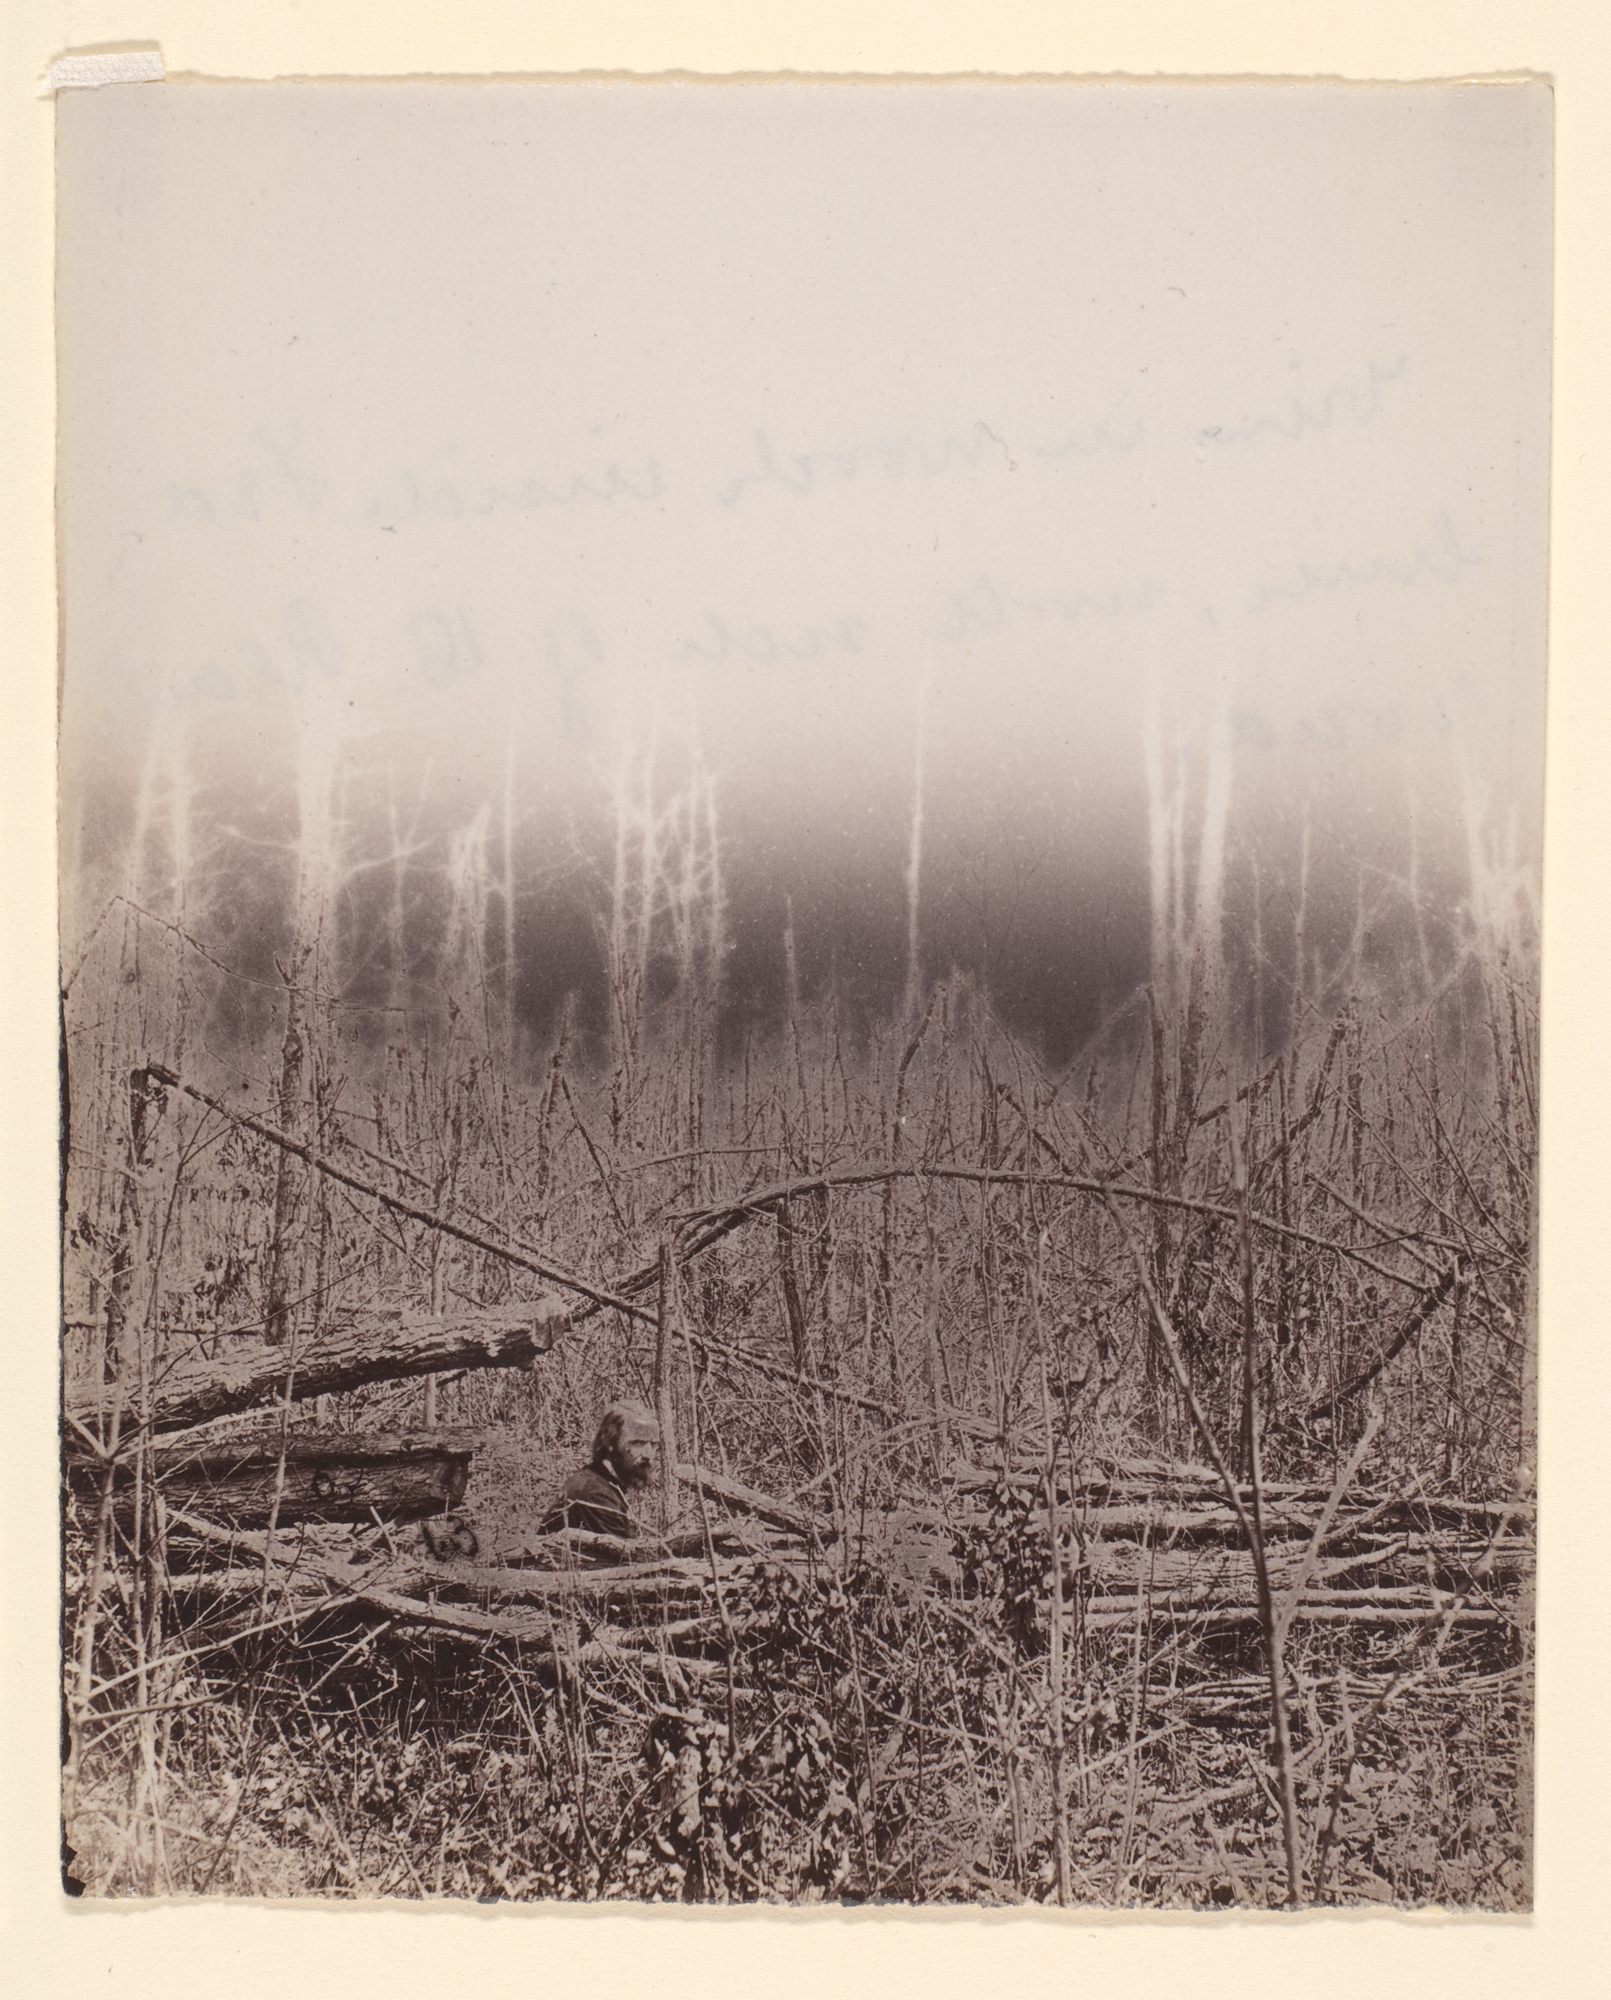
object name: photograph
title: [The Wilderness Battlefield]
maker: g. o. brown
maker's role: artist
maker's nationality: american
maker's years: 1860-1889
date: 1866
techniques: albumen silver print, glass negative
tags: american civil war,men